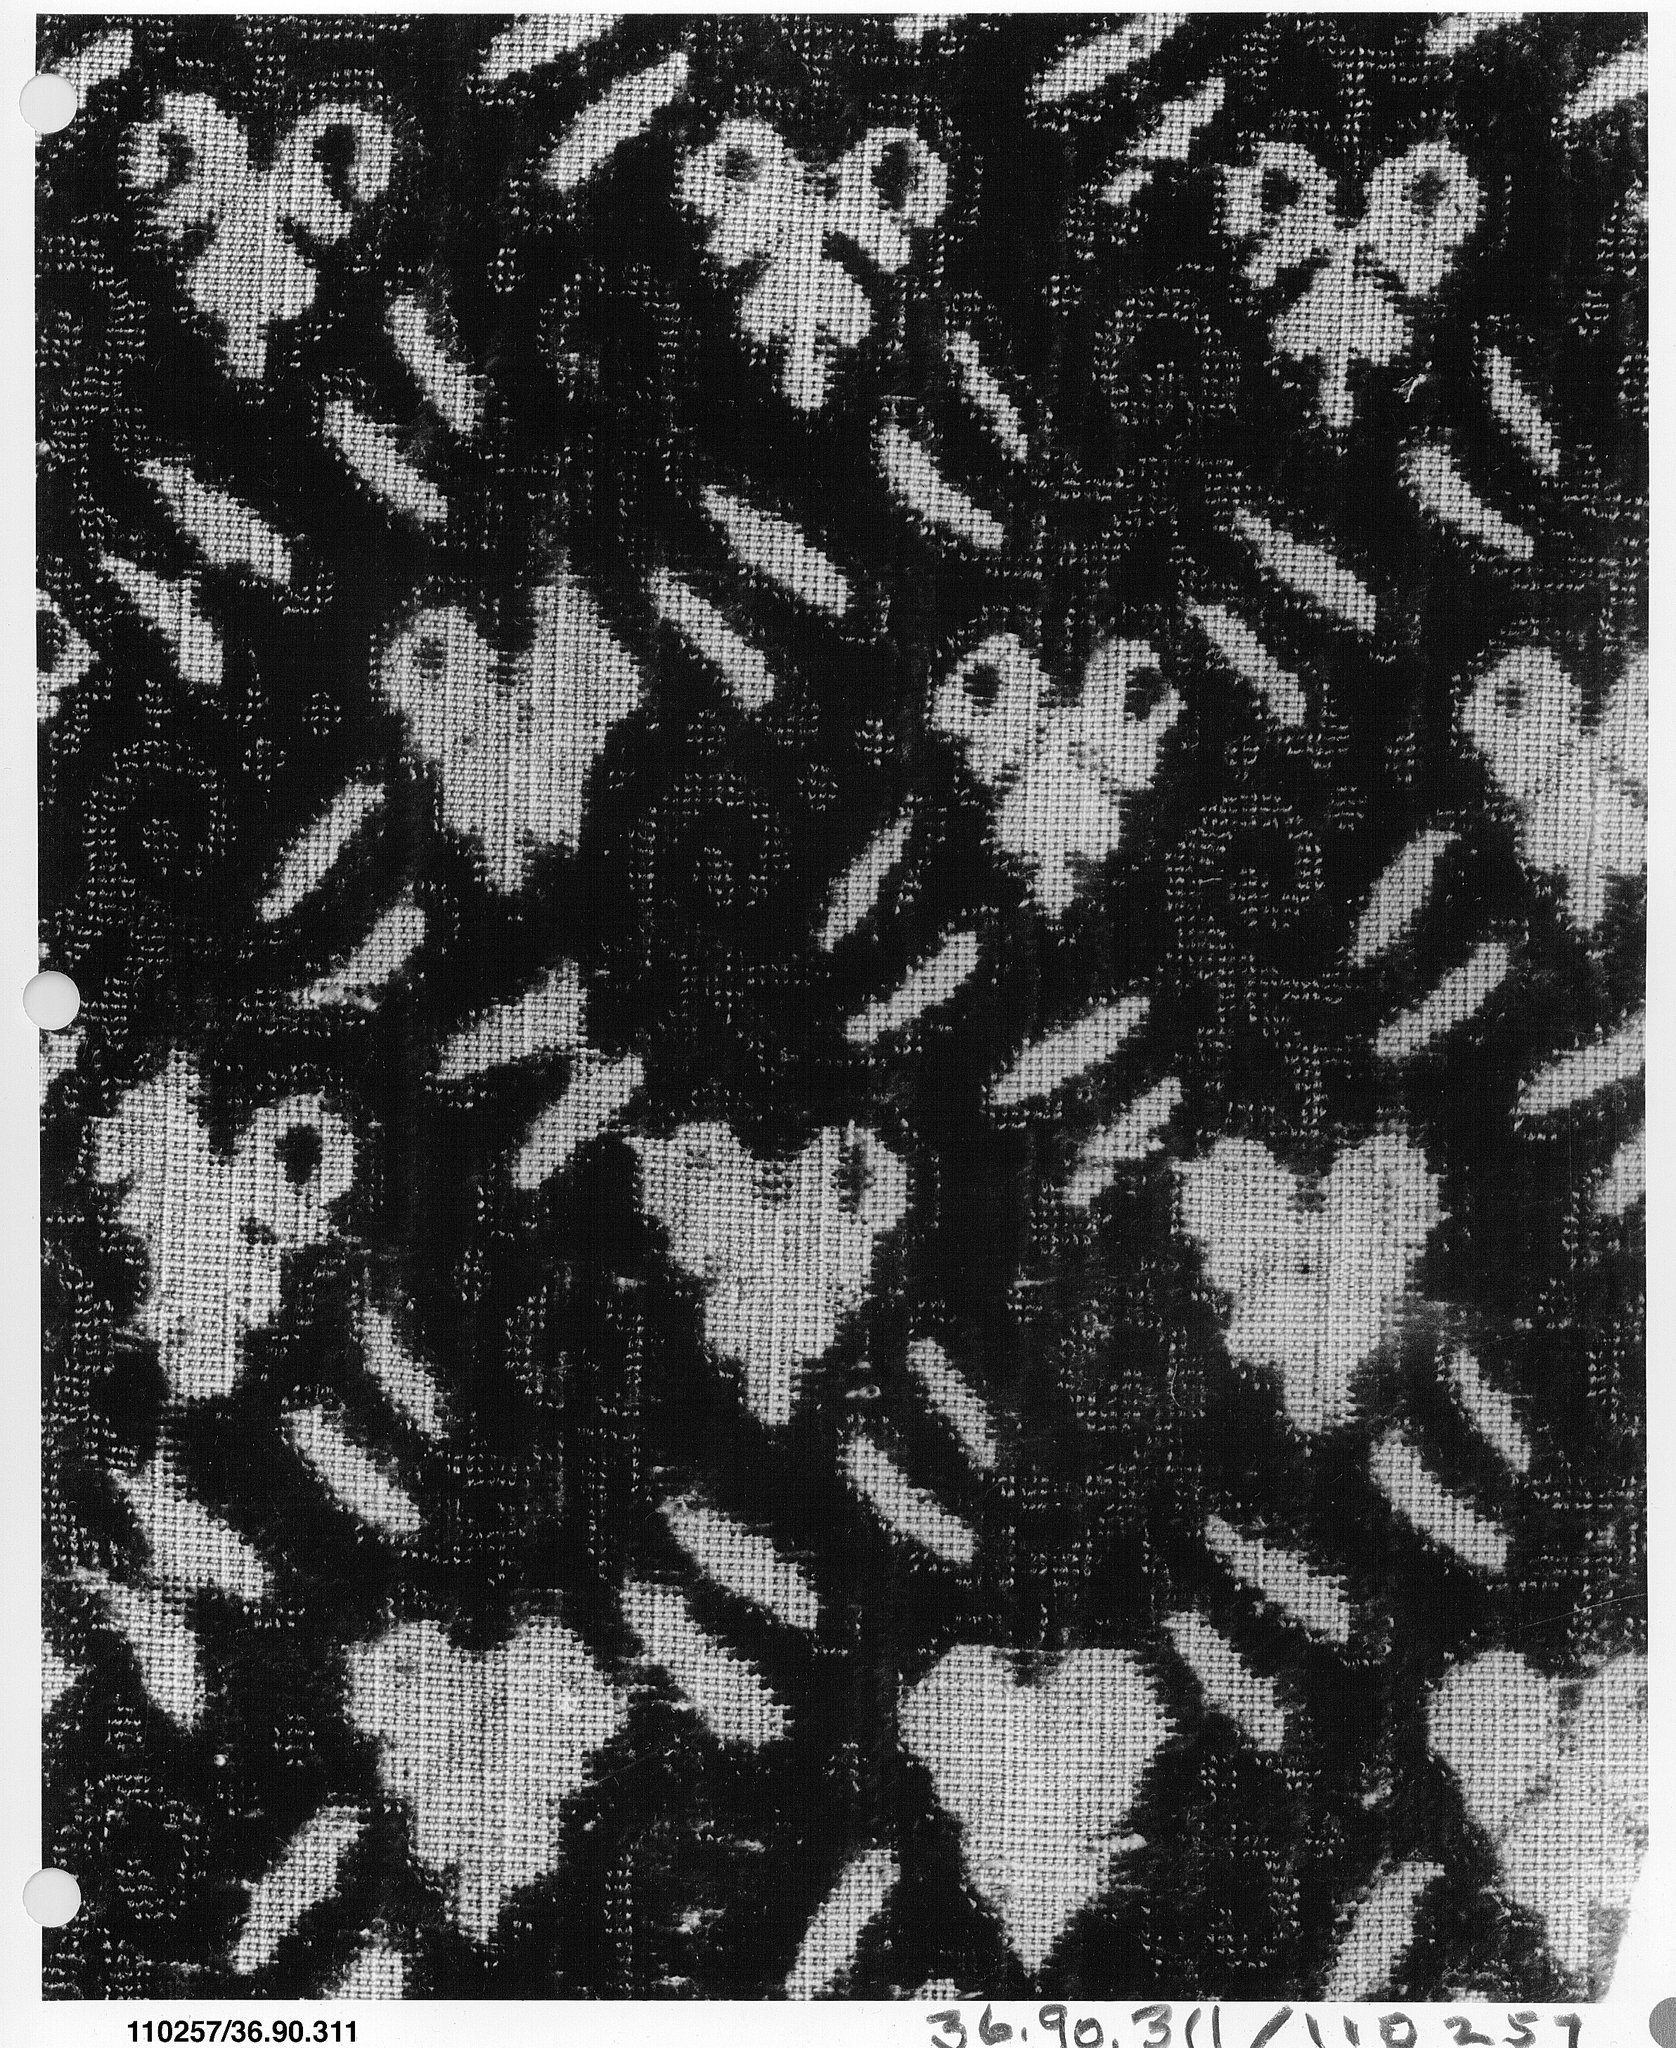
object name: piece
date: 1501-1700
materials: silk